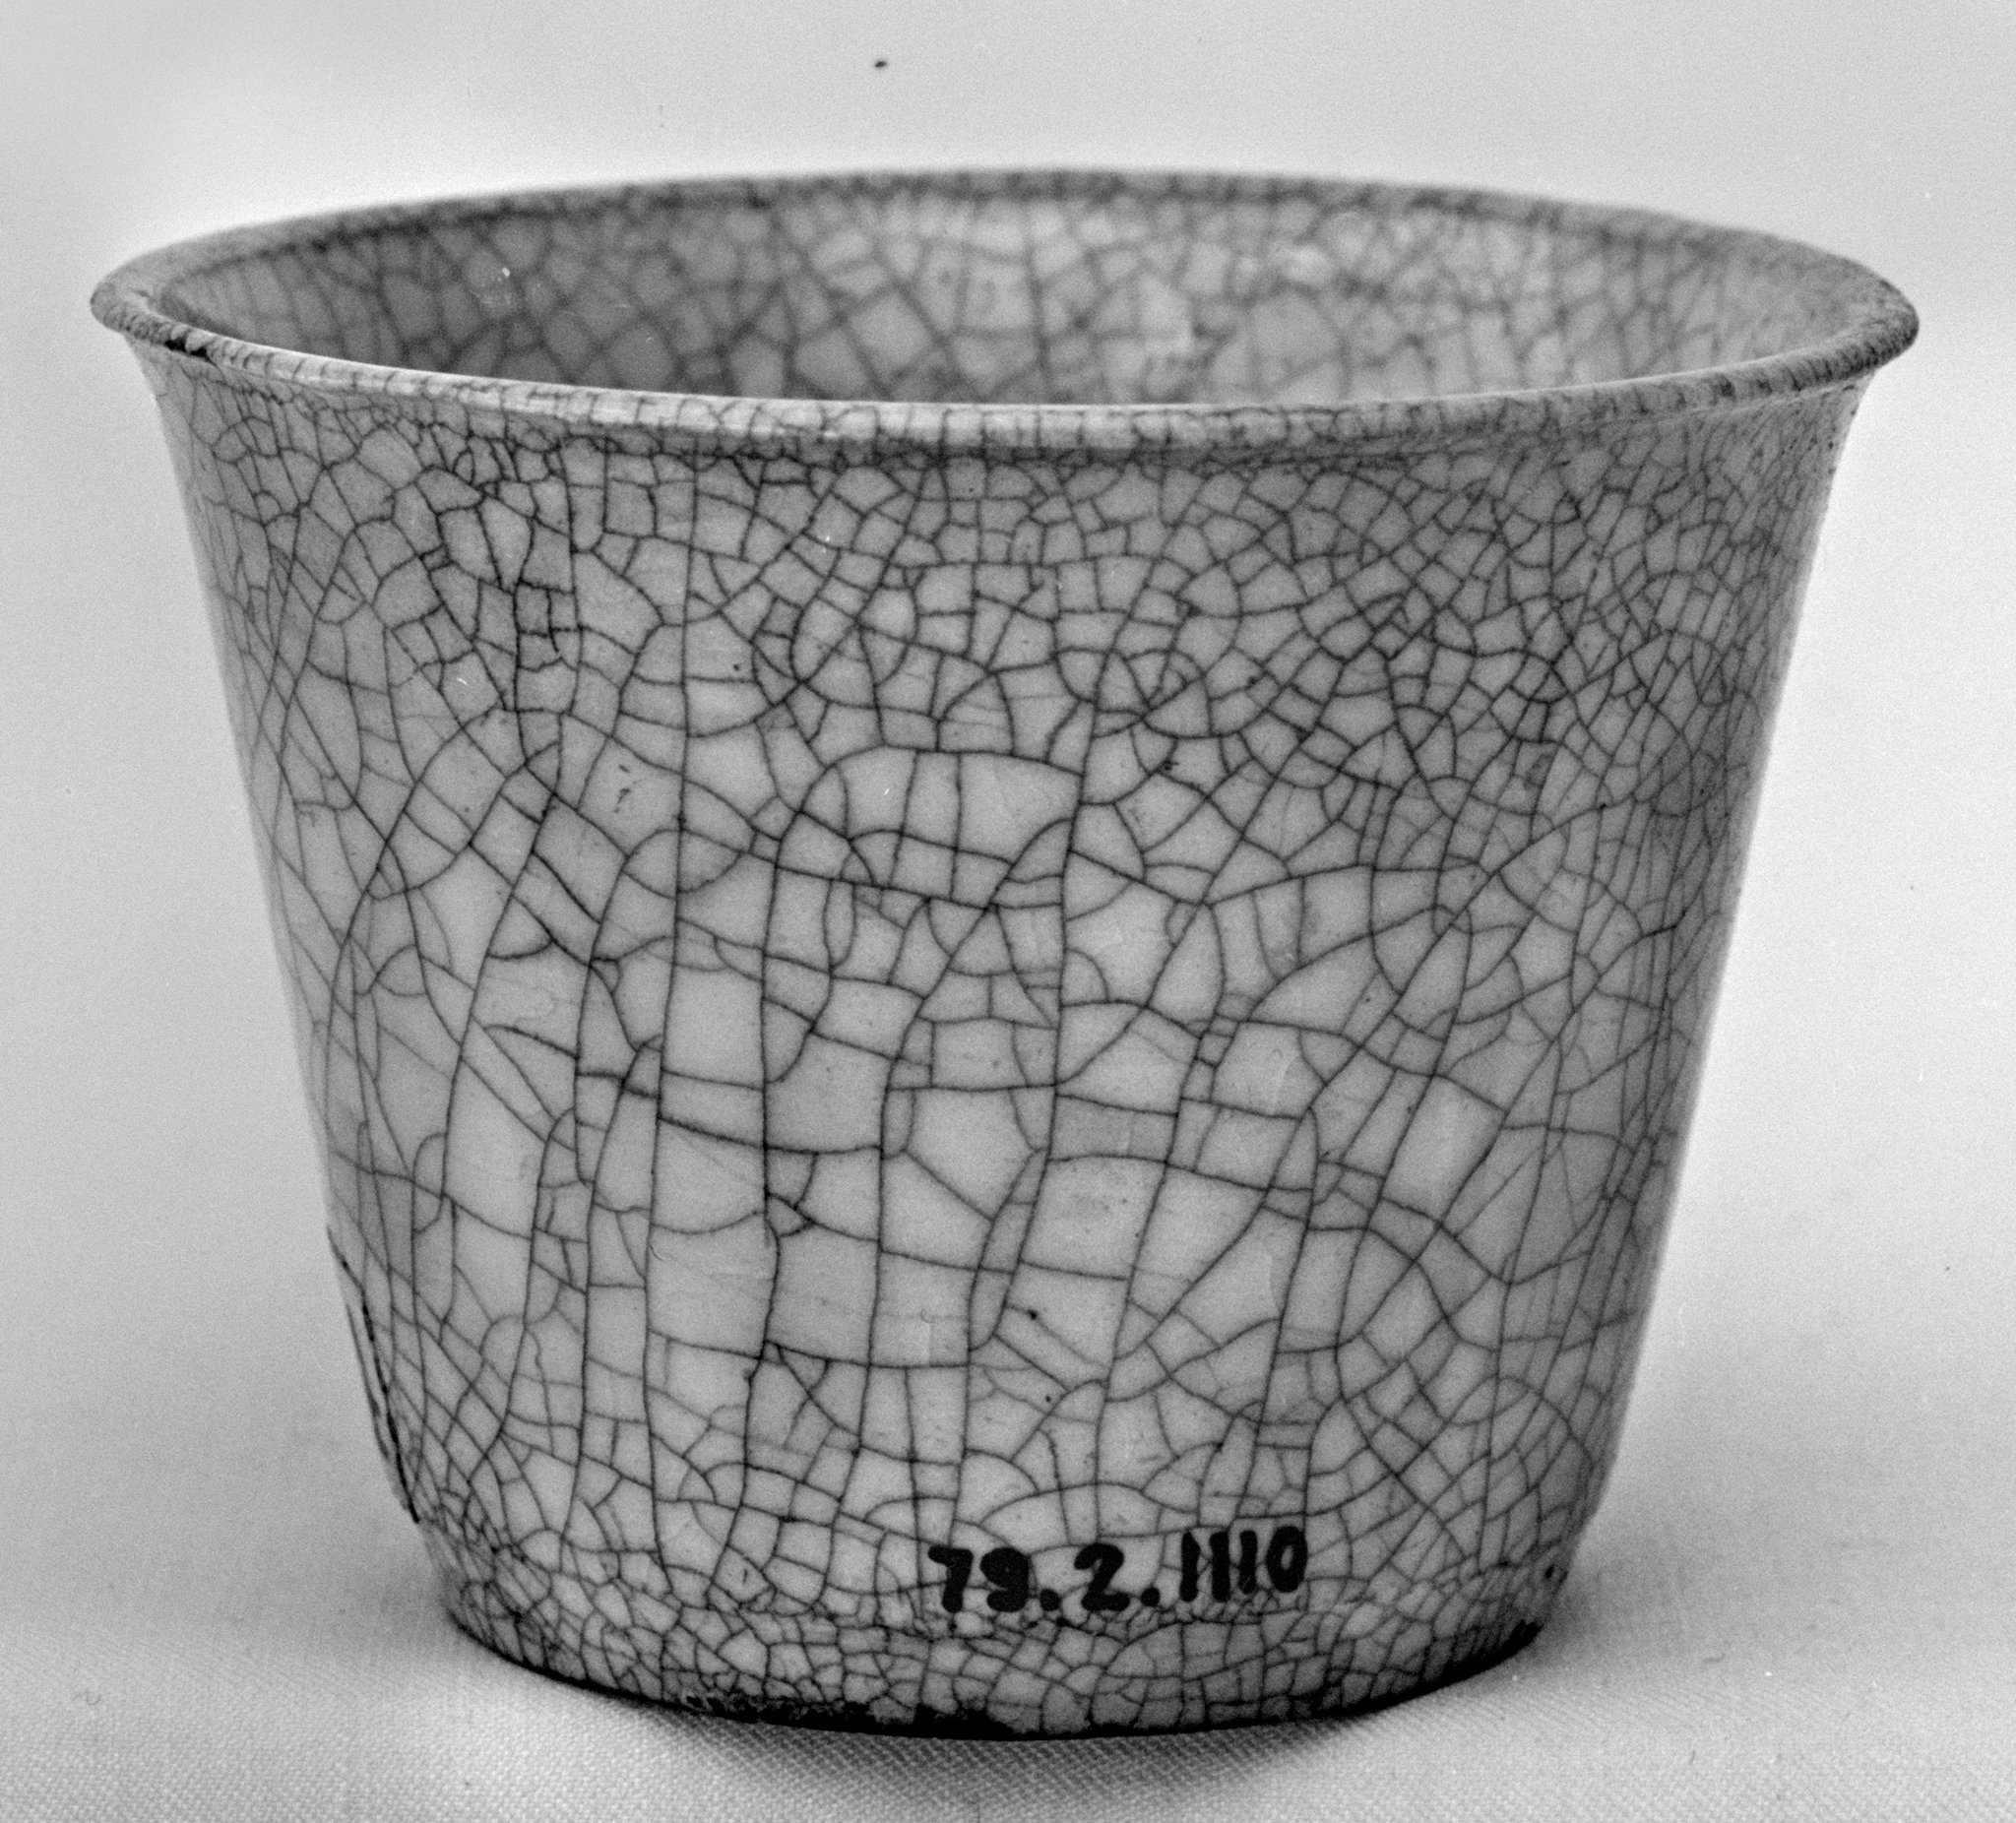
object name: cup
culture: chinese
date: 1801-1850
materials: glaze, porcelain